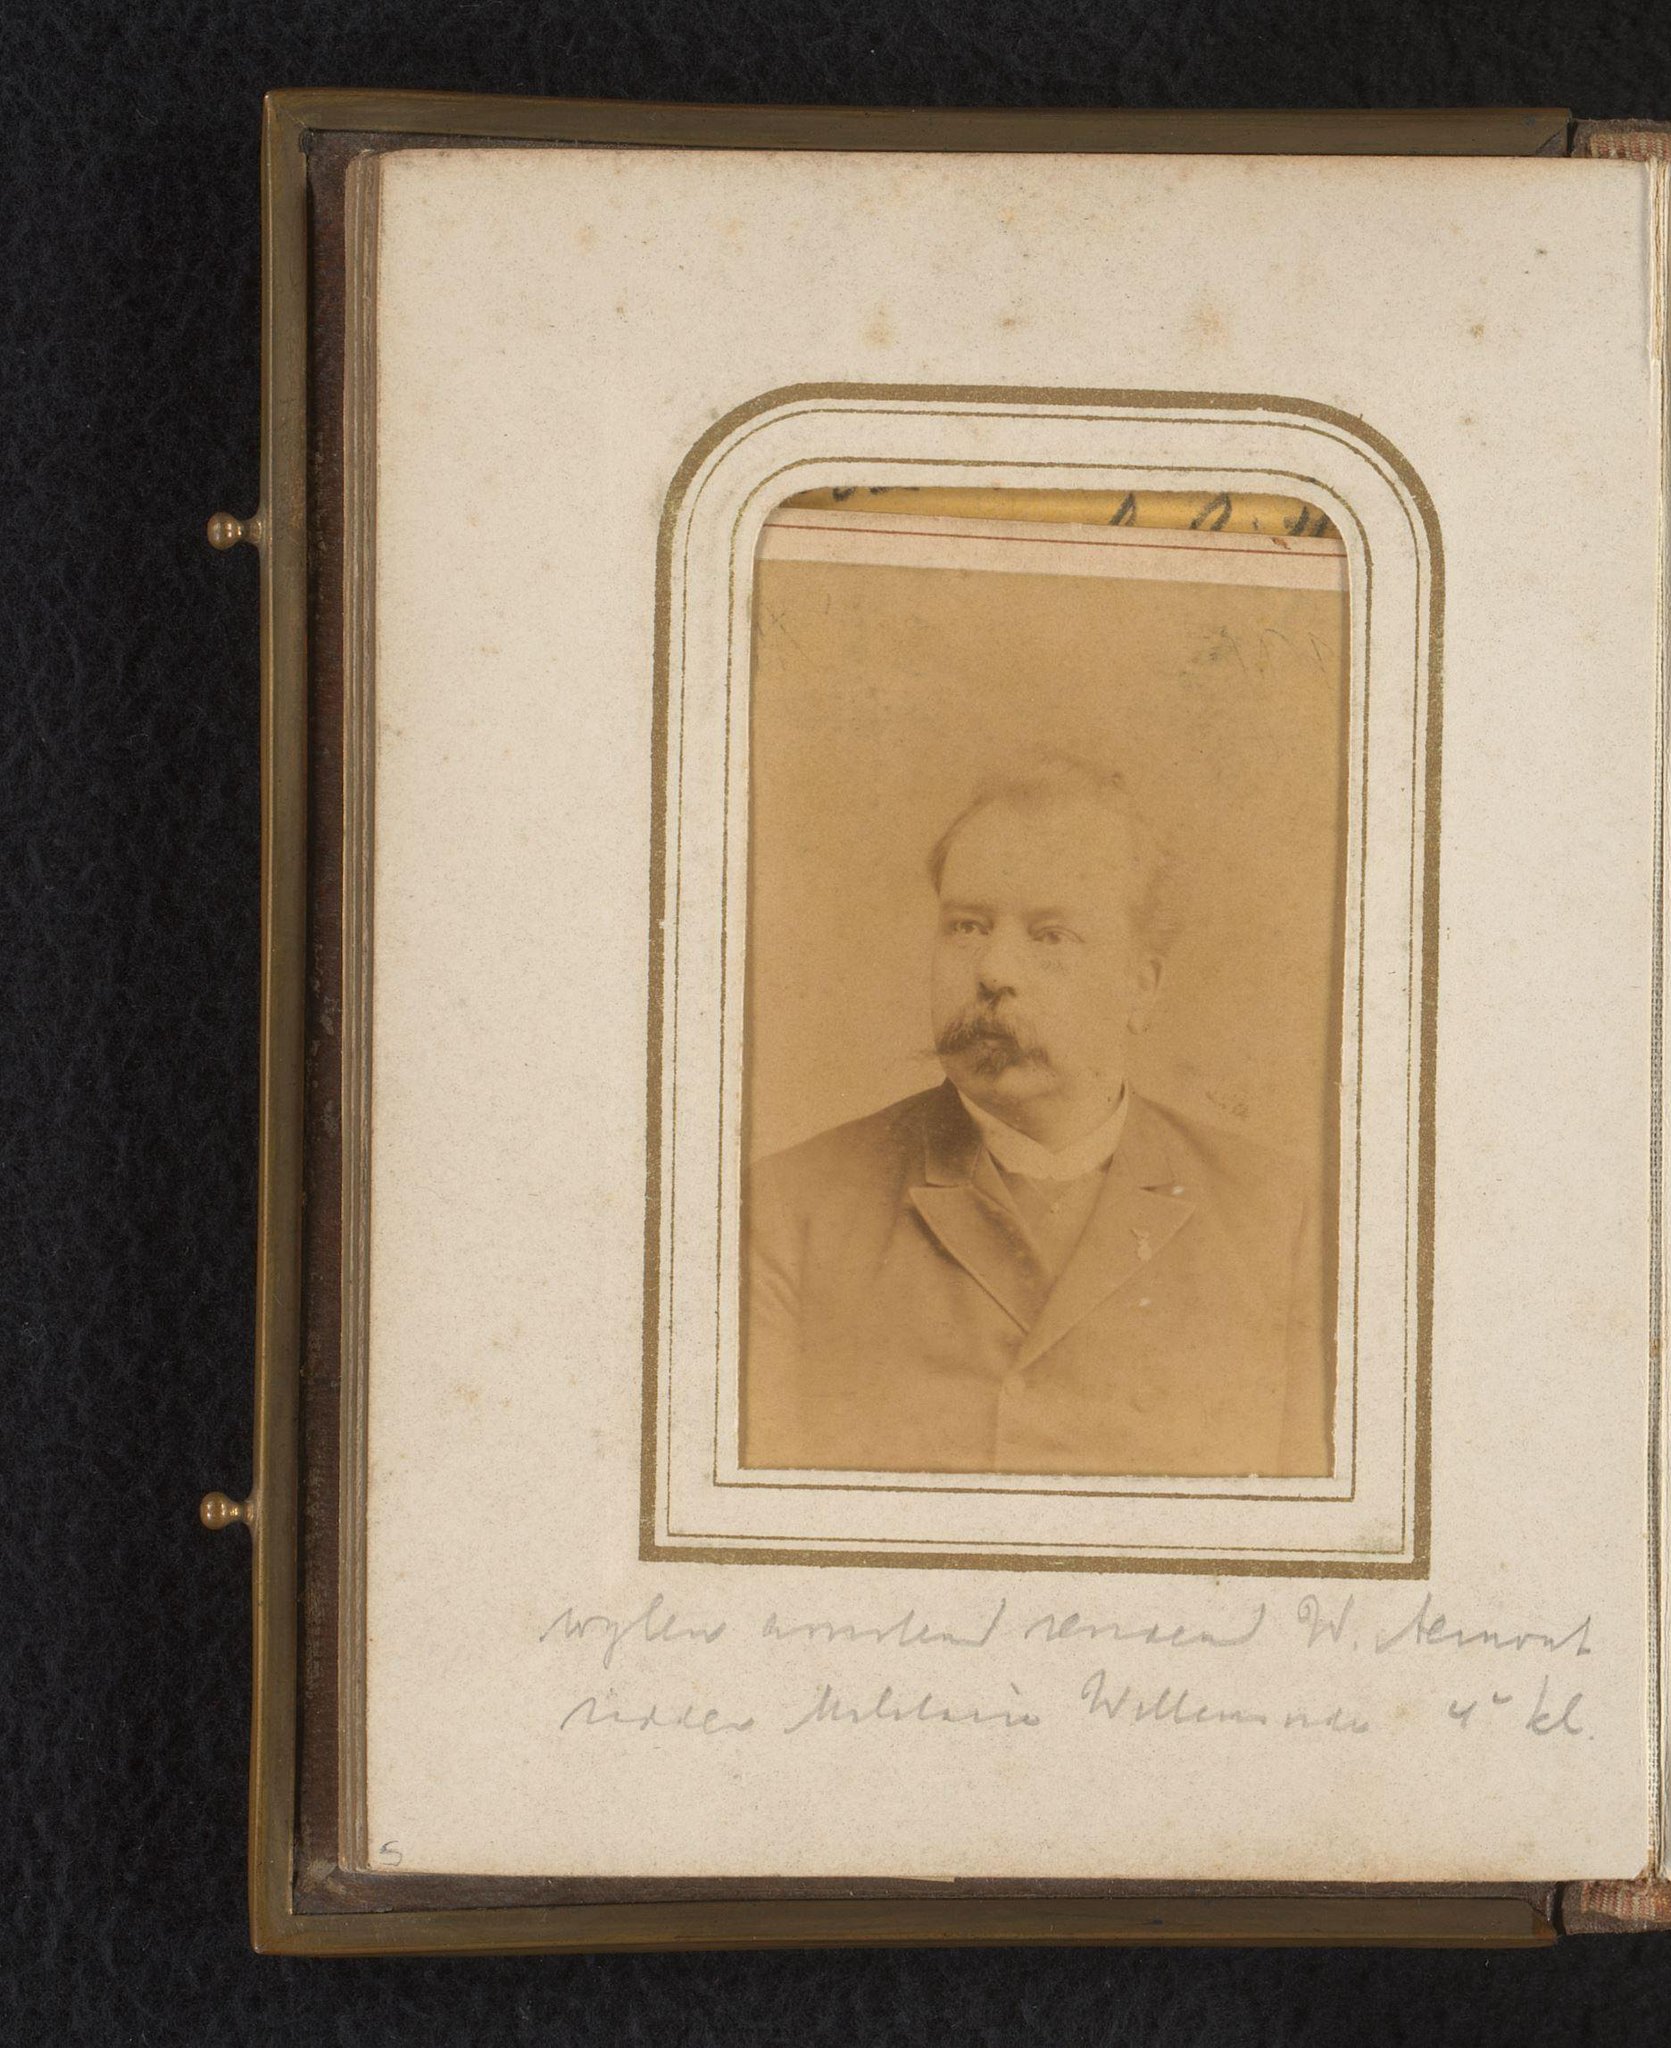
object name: carte de visite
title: Portret van een man met snor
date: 1857-1908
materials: cardboard, photographic support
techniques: albumen print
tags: adult woman, moustache, historical persons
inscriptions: annotation: ‘[...] W. Aernout/ R. M. W.O. 4. Kl.’, annotation: ‘Wijlen [...] W. Aernout/ ridder militaire Willemsorde 4e kl.’, inscription: ‘Woodbury & Page/ Java’